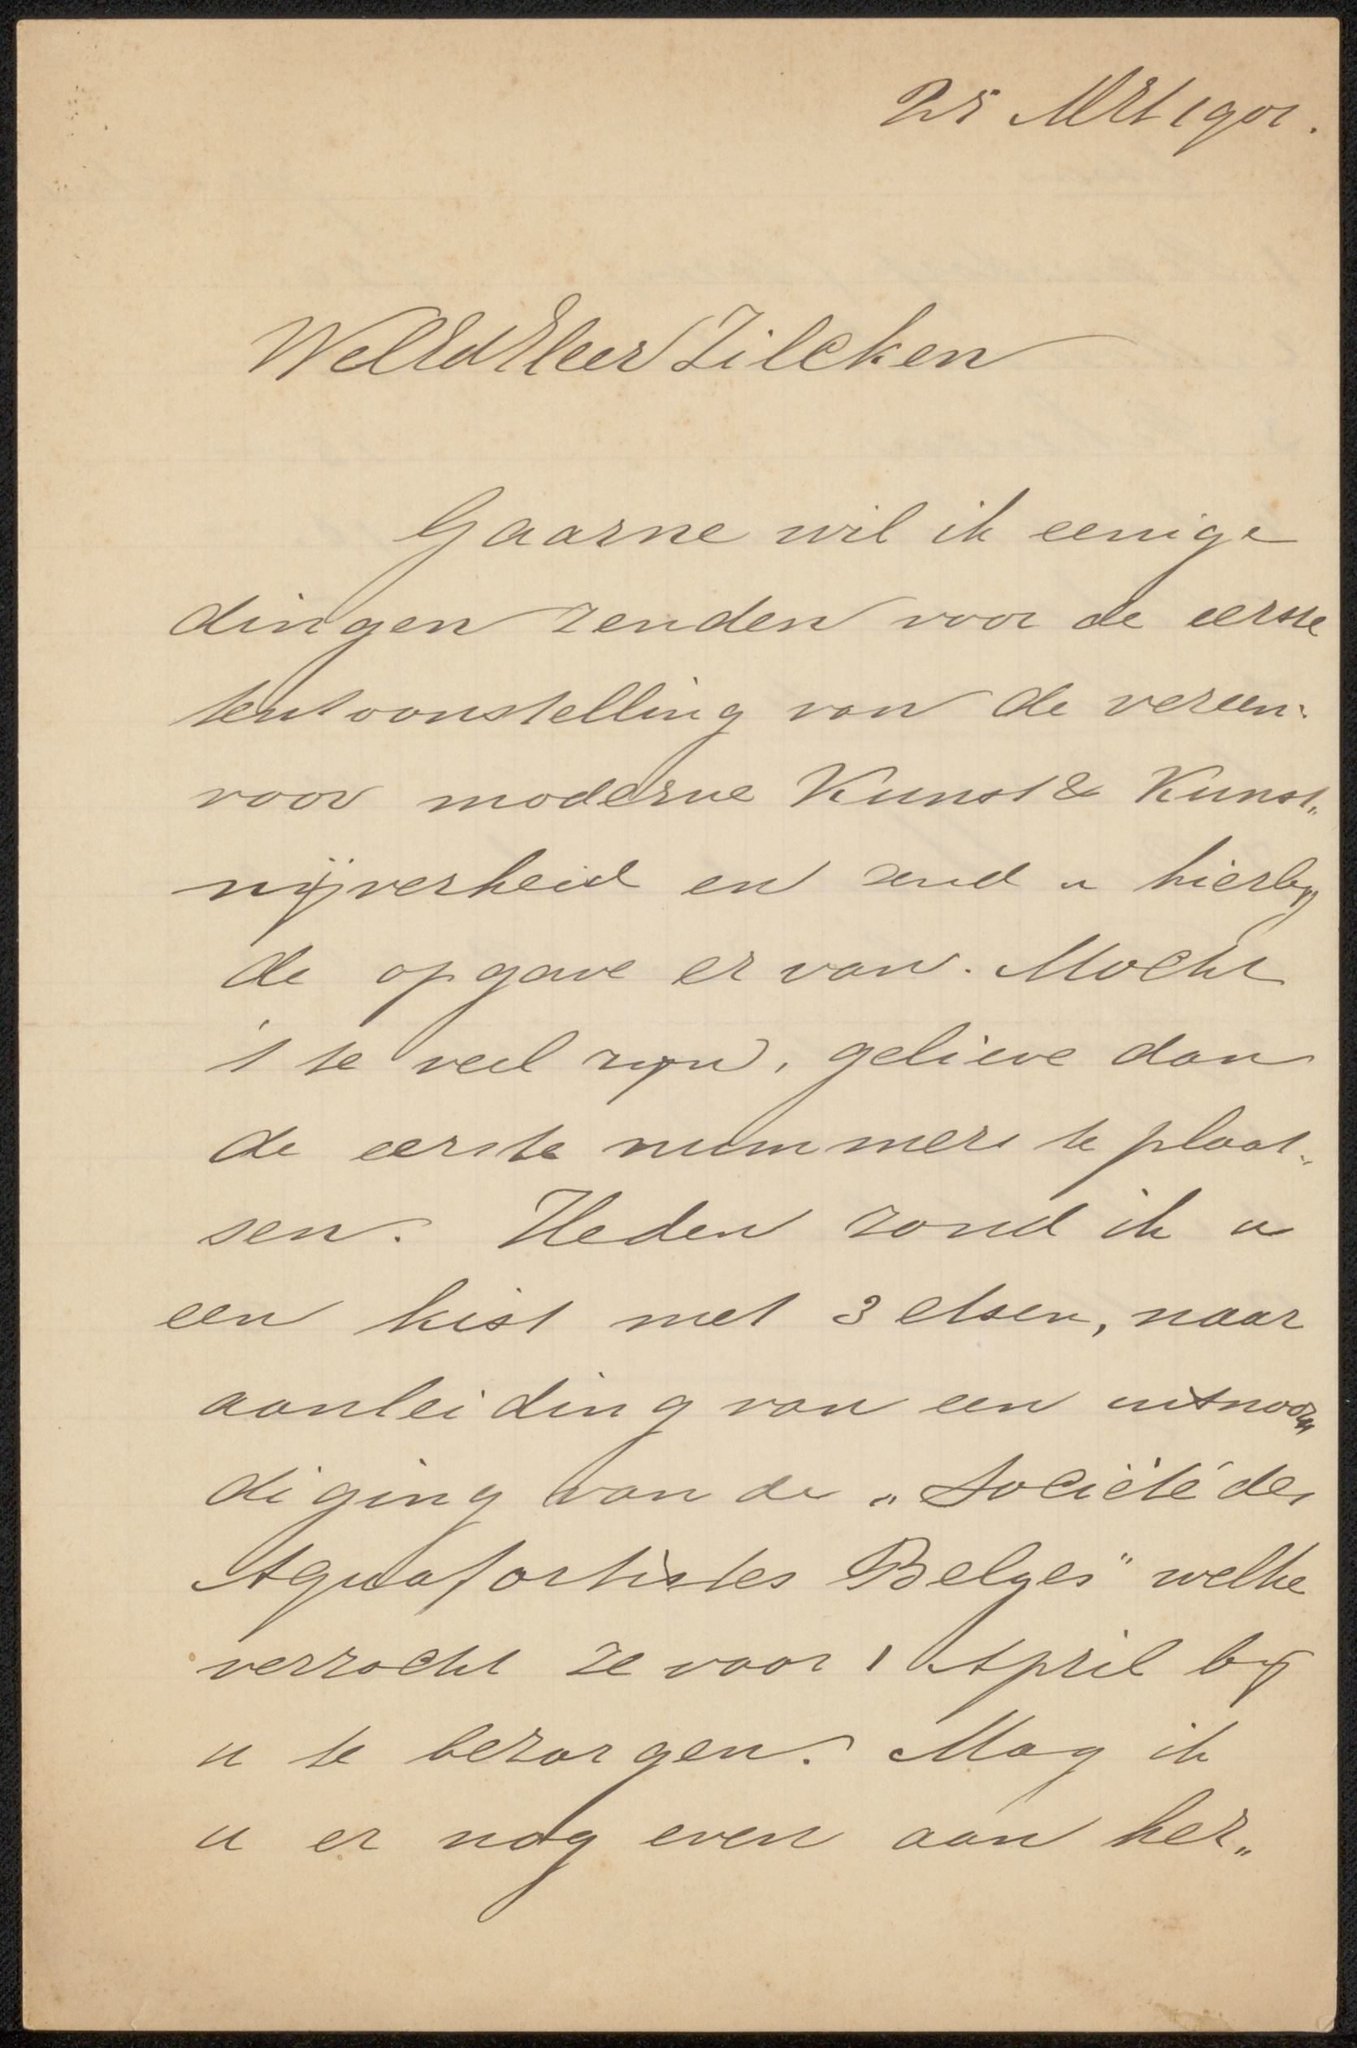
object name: letter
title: Brief aan Philip Zilcken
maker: wijnand otto jan nieuwenkamp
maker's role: draughtsman, print maker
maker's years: 1874-1950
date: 1901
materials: ink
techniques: pen, writing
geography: oude wetering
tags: publisher, the hague, philip zilcken, drawing, the graphic arts, exhibition ~ art, money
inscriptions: collector's mark: ‘RPK’